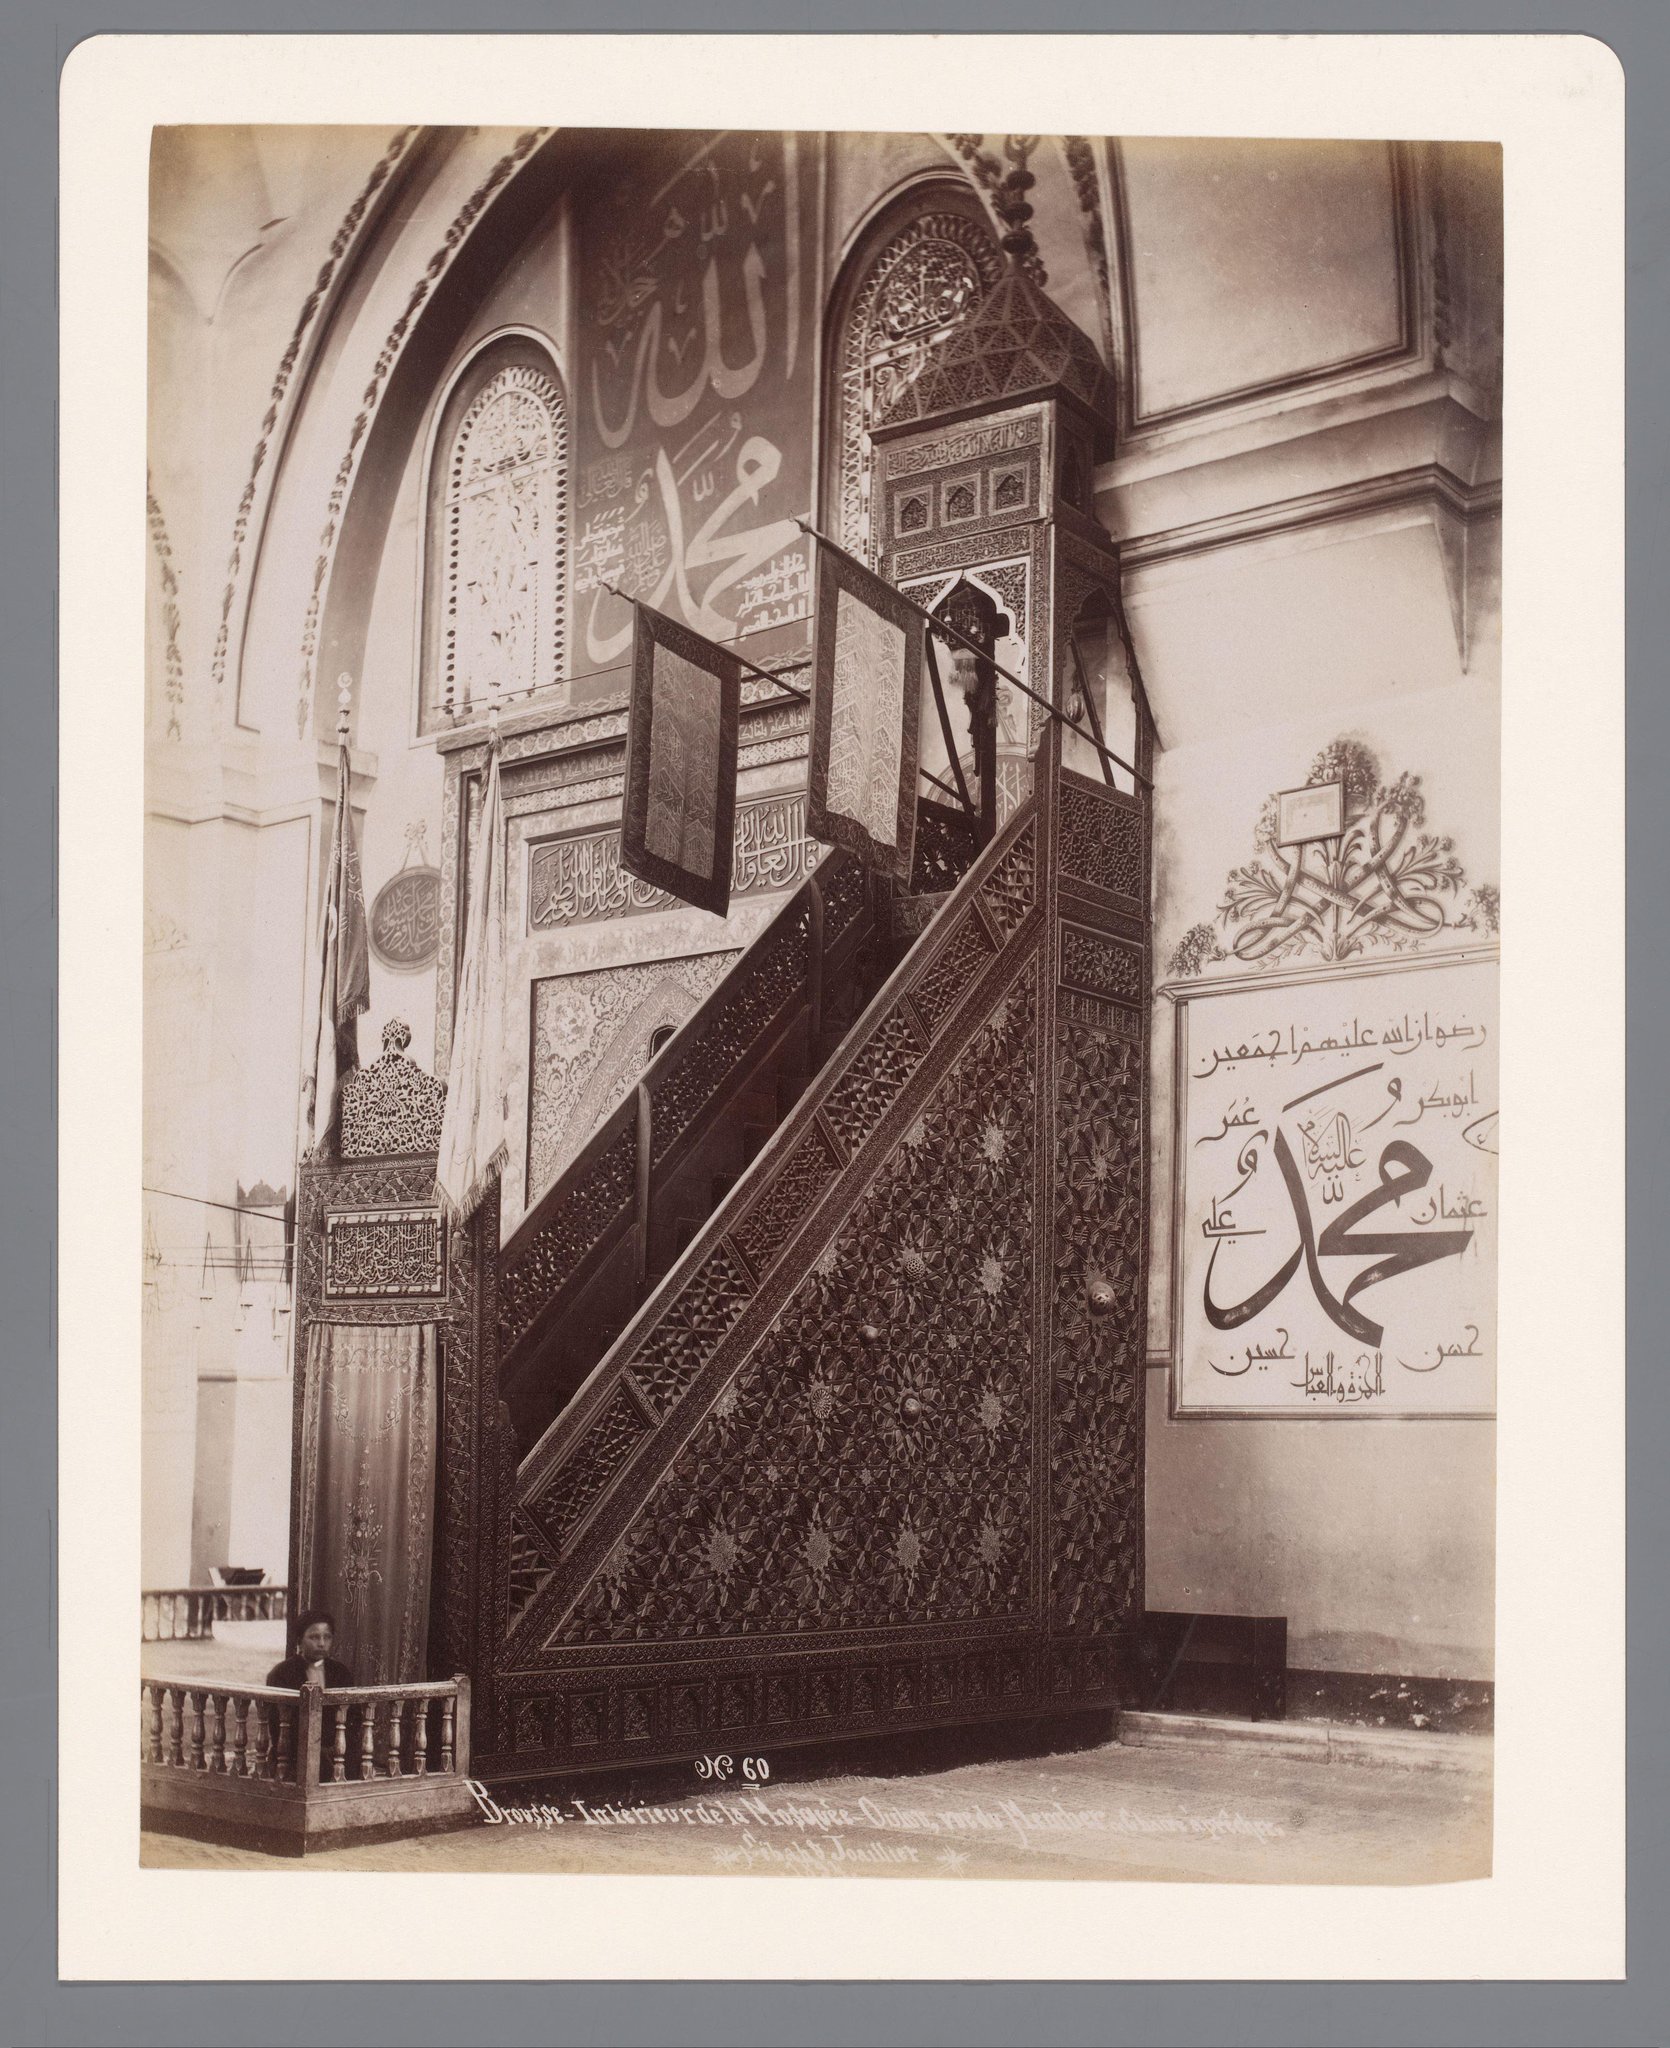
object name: photograph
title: Minbar van de Grote Moskee van Bursa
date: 1894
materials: paper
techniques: albumen print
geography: bursa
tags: temple, shrine ~ islam, mohammedanism, grand mosque of bursa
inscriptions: number: ‘No 60’